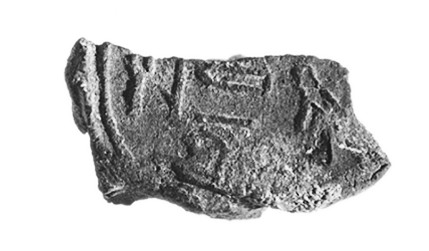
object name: sealing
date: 1981-1640 BCE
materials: mud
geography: egypt